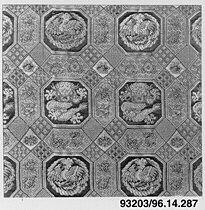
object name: piece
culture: japanese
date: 1701-1900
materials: silk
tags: dragons